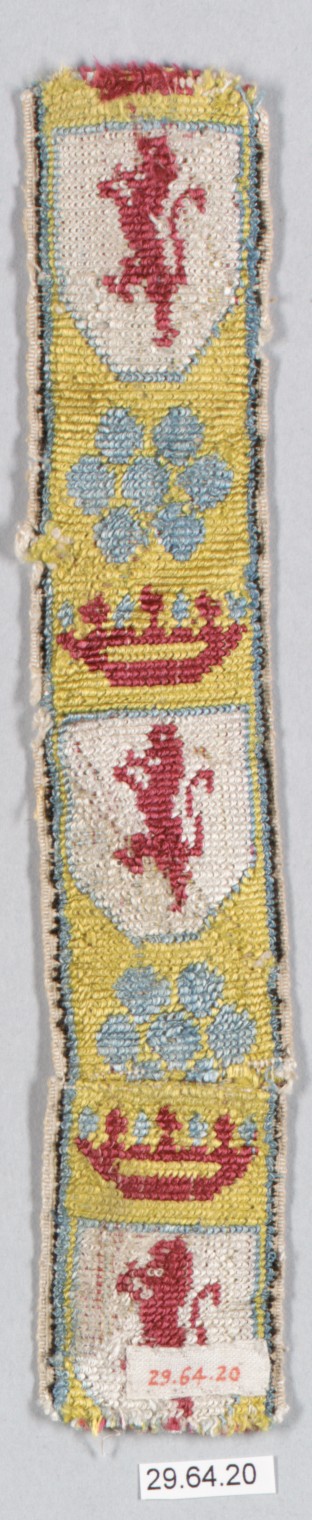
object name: galloon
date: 1701-1900